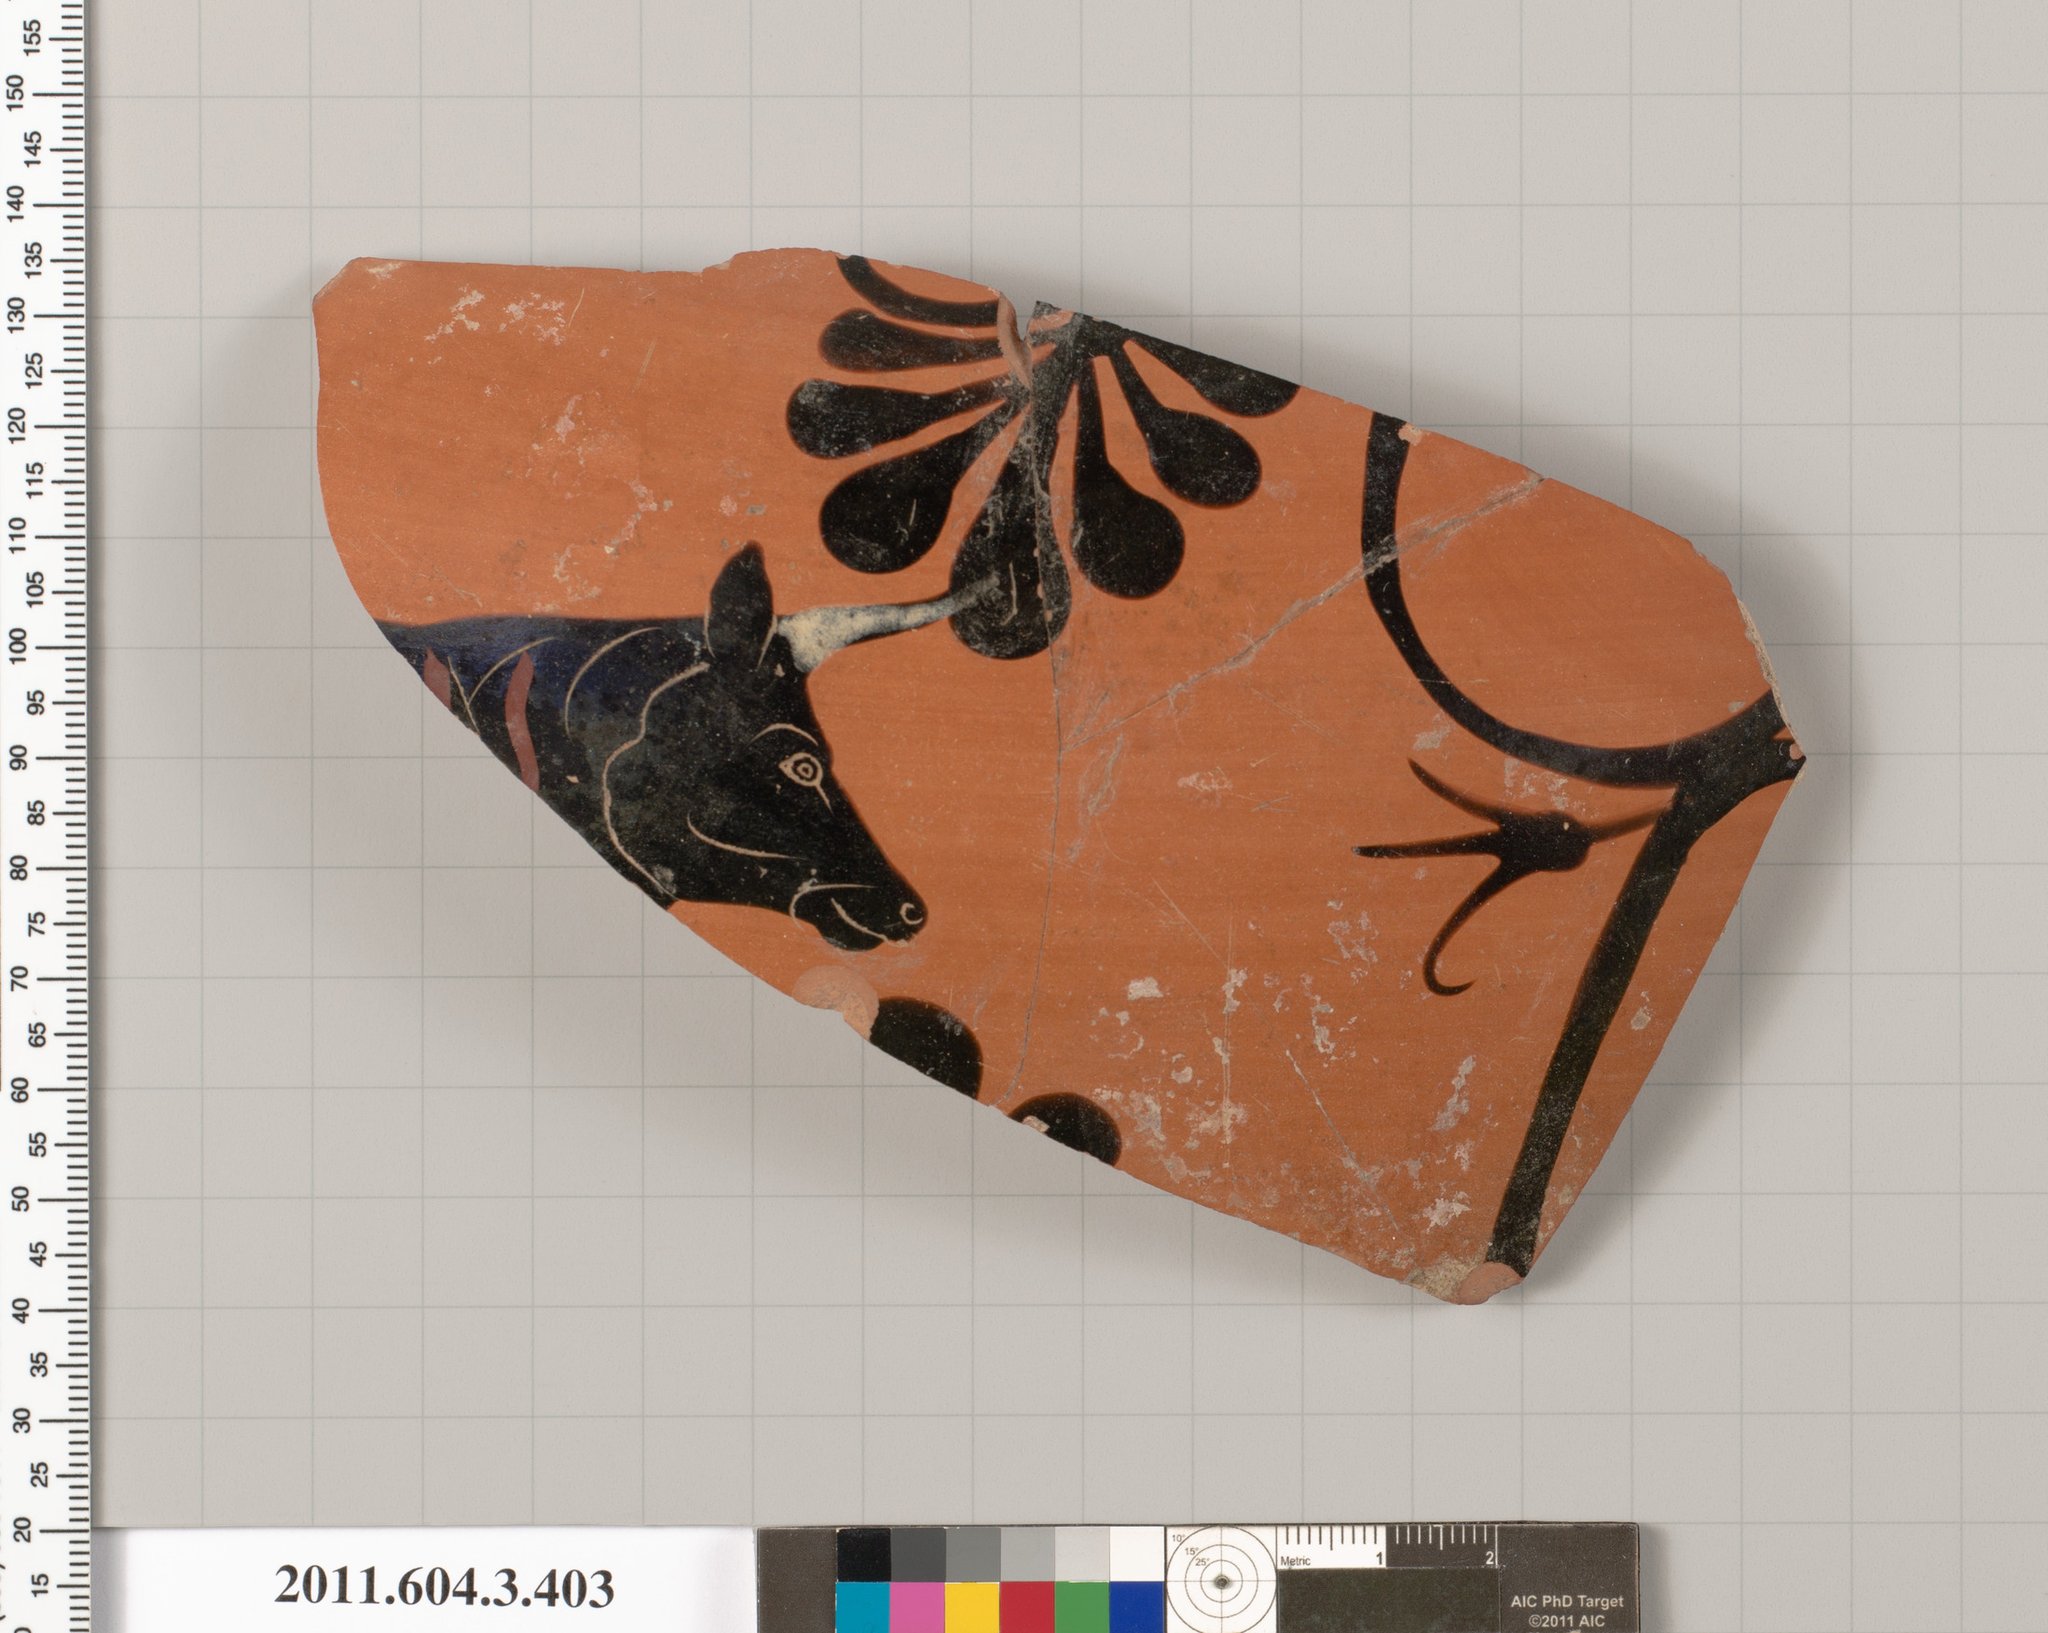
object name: neck amphora fragment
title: Terracotta fragment of a neck-amphora (jar)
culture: greek, attic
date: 530-520 BCE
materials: terracotta